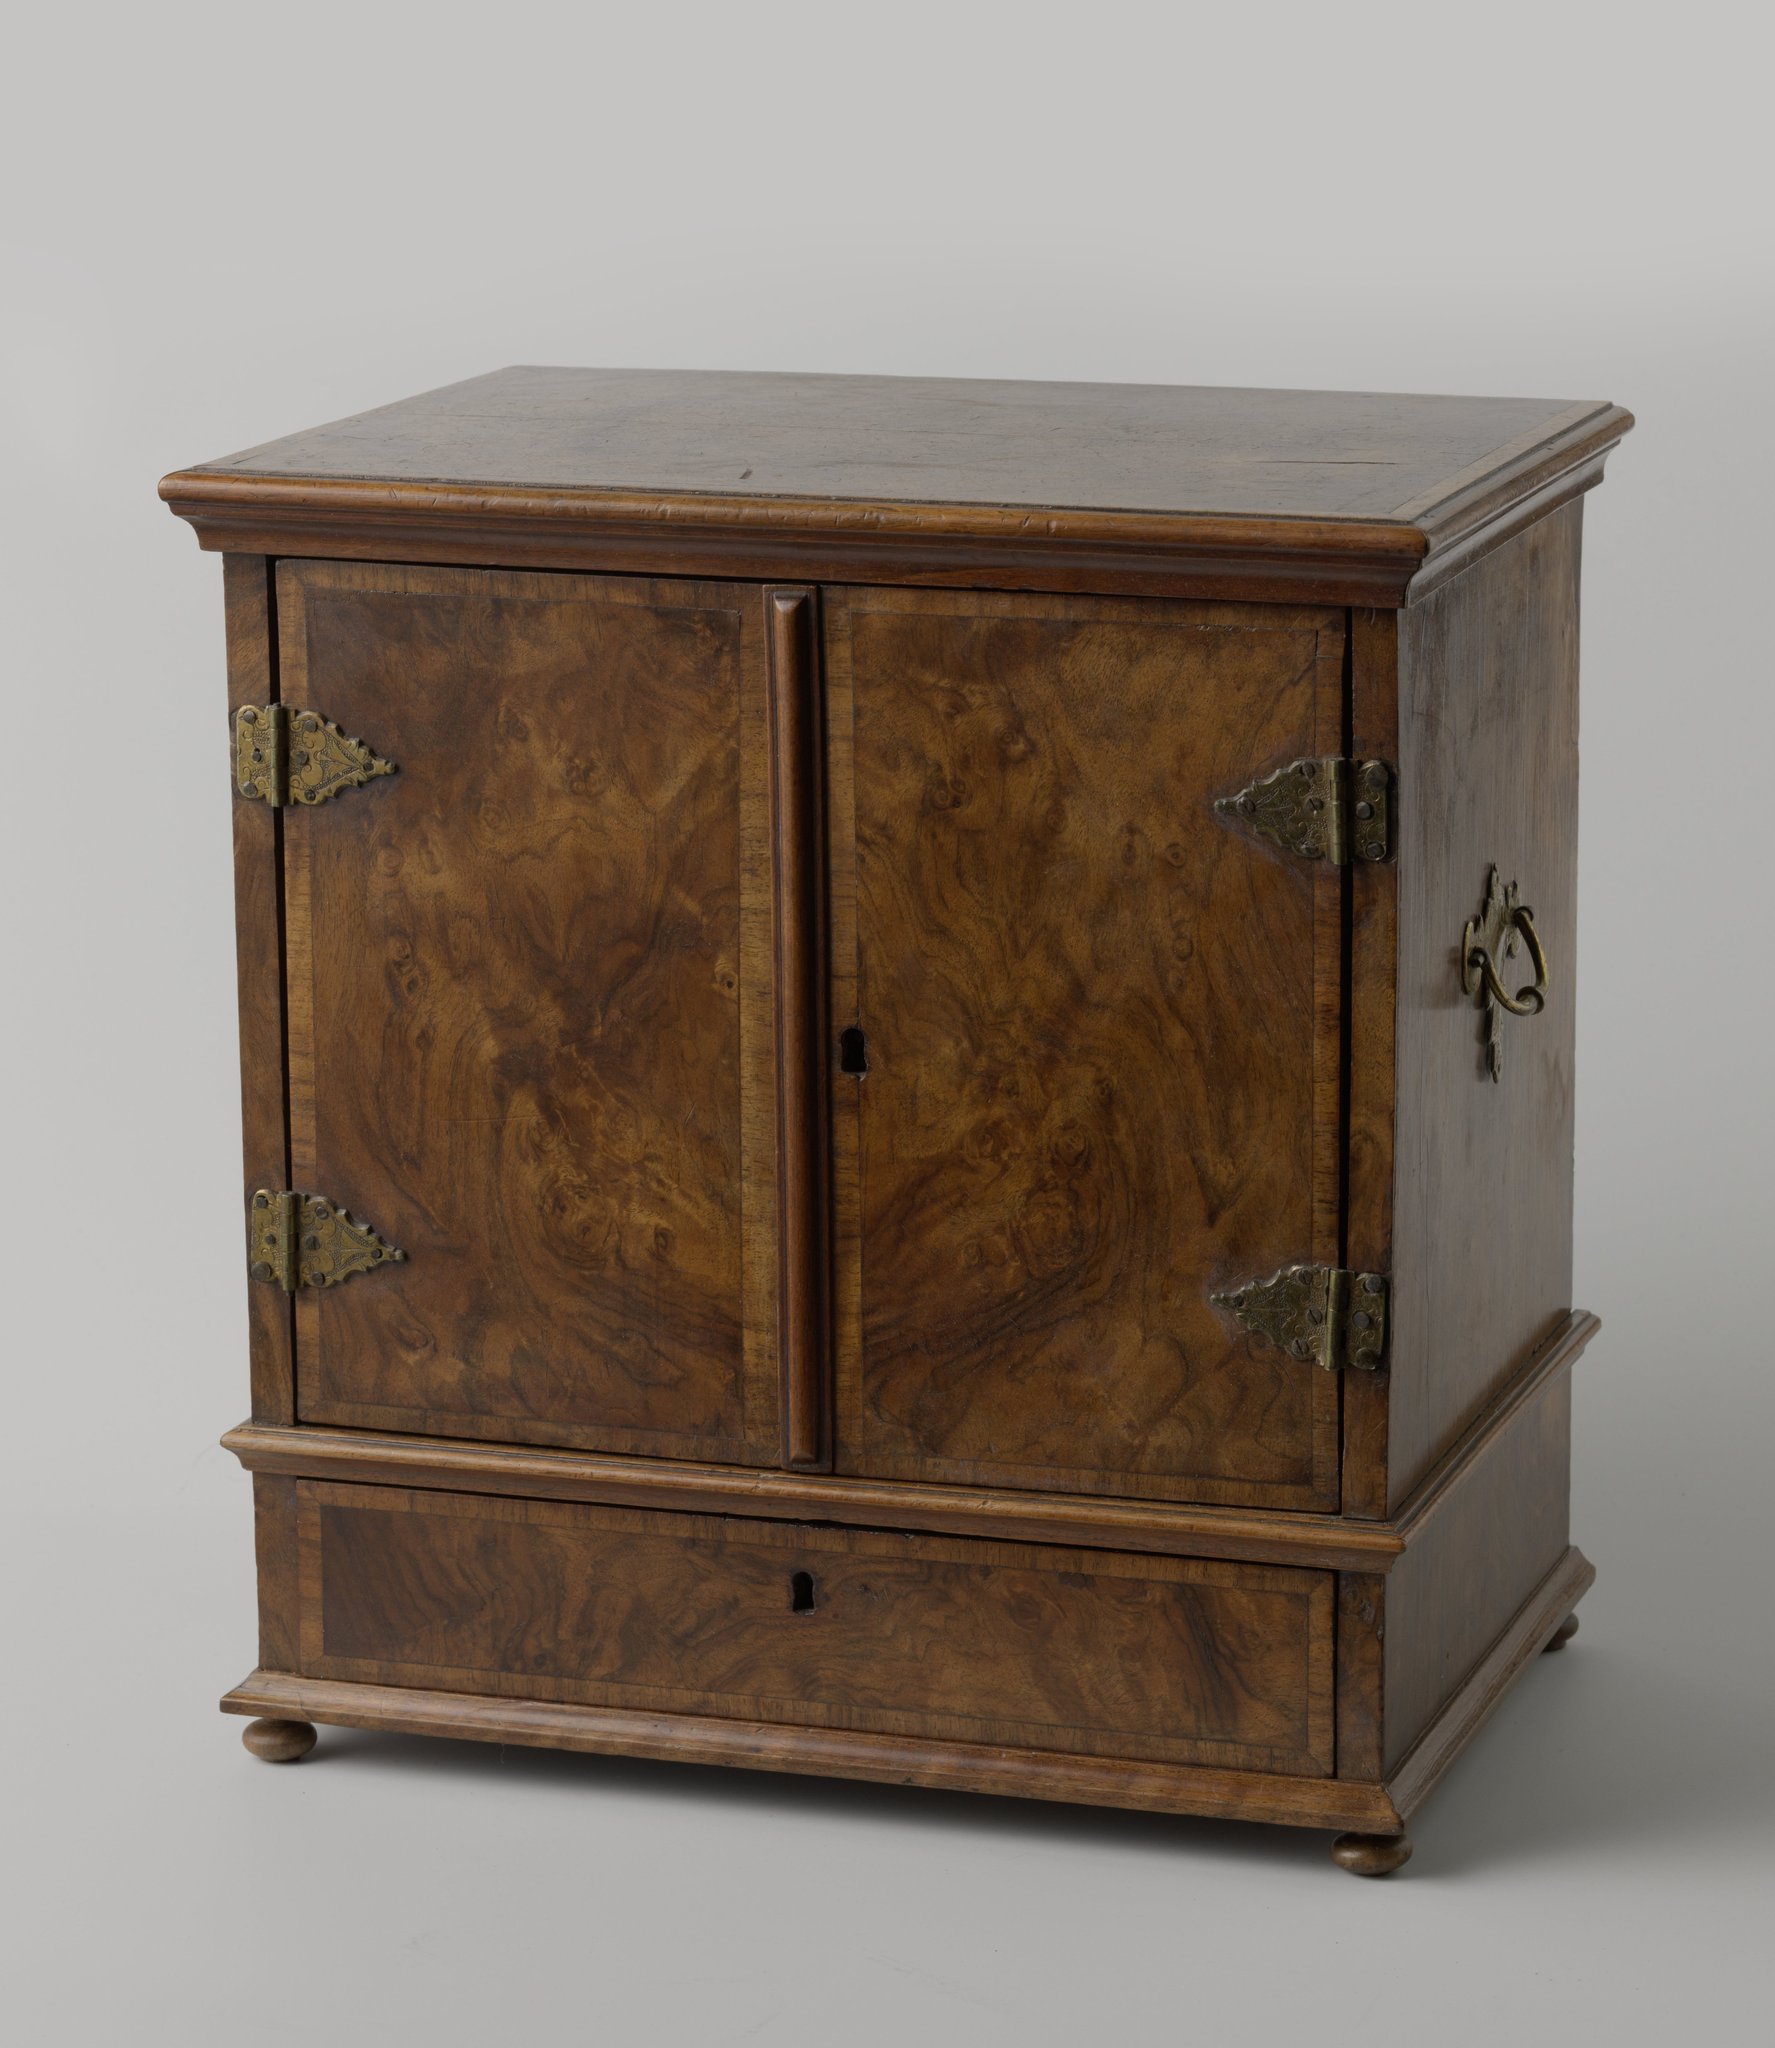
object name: coin cabinet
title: Penningkabinet met twee deuren waarachter tien laden, een lade en klep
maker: Anonymous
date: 1690-1710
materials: brass, wood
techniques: veneering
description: Penningkabinet op vier gedraaide poten, met twee deuren waarachter tien laden met messing knoppen. De deuren hebben gegraveerde scharnieren. Onder de deuren zit een lade; het kabinet heeft een klep aan de bovenkant. Handgrepen aan de zijkanten van het meubel. Deuren en lade voorzien van een slot.(